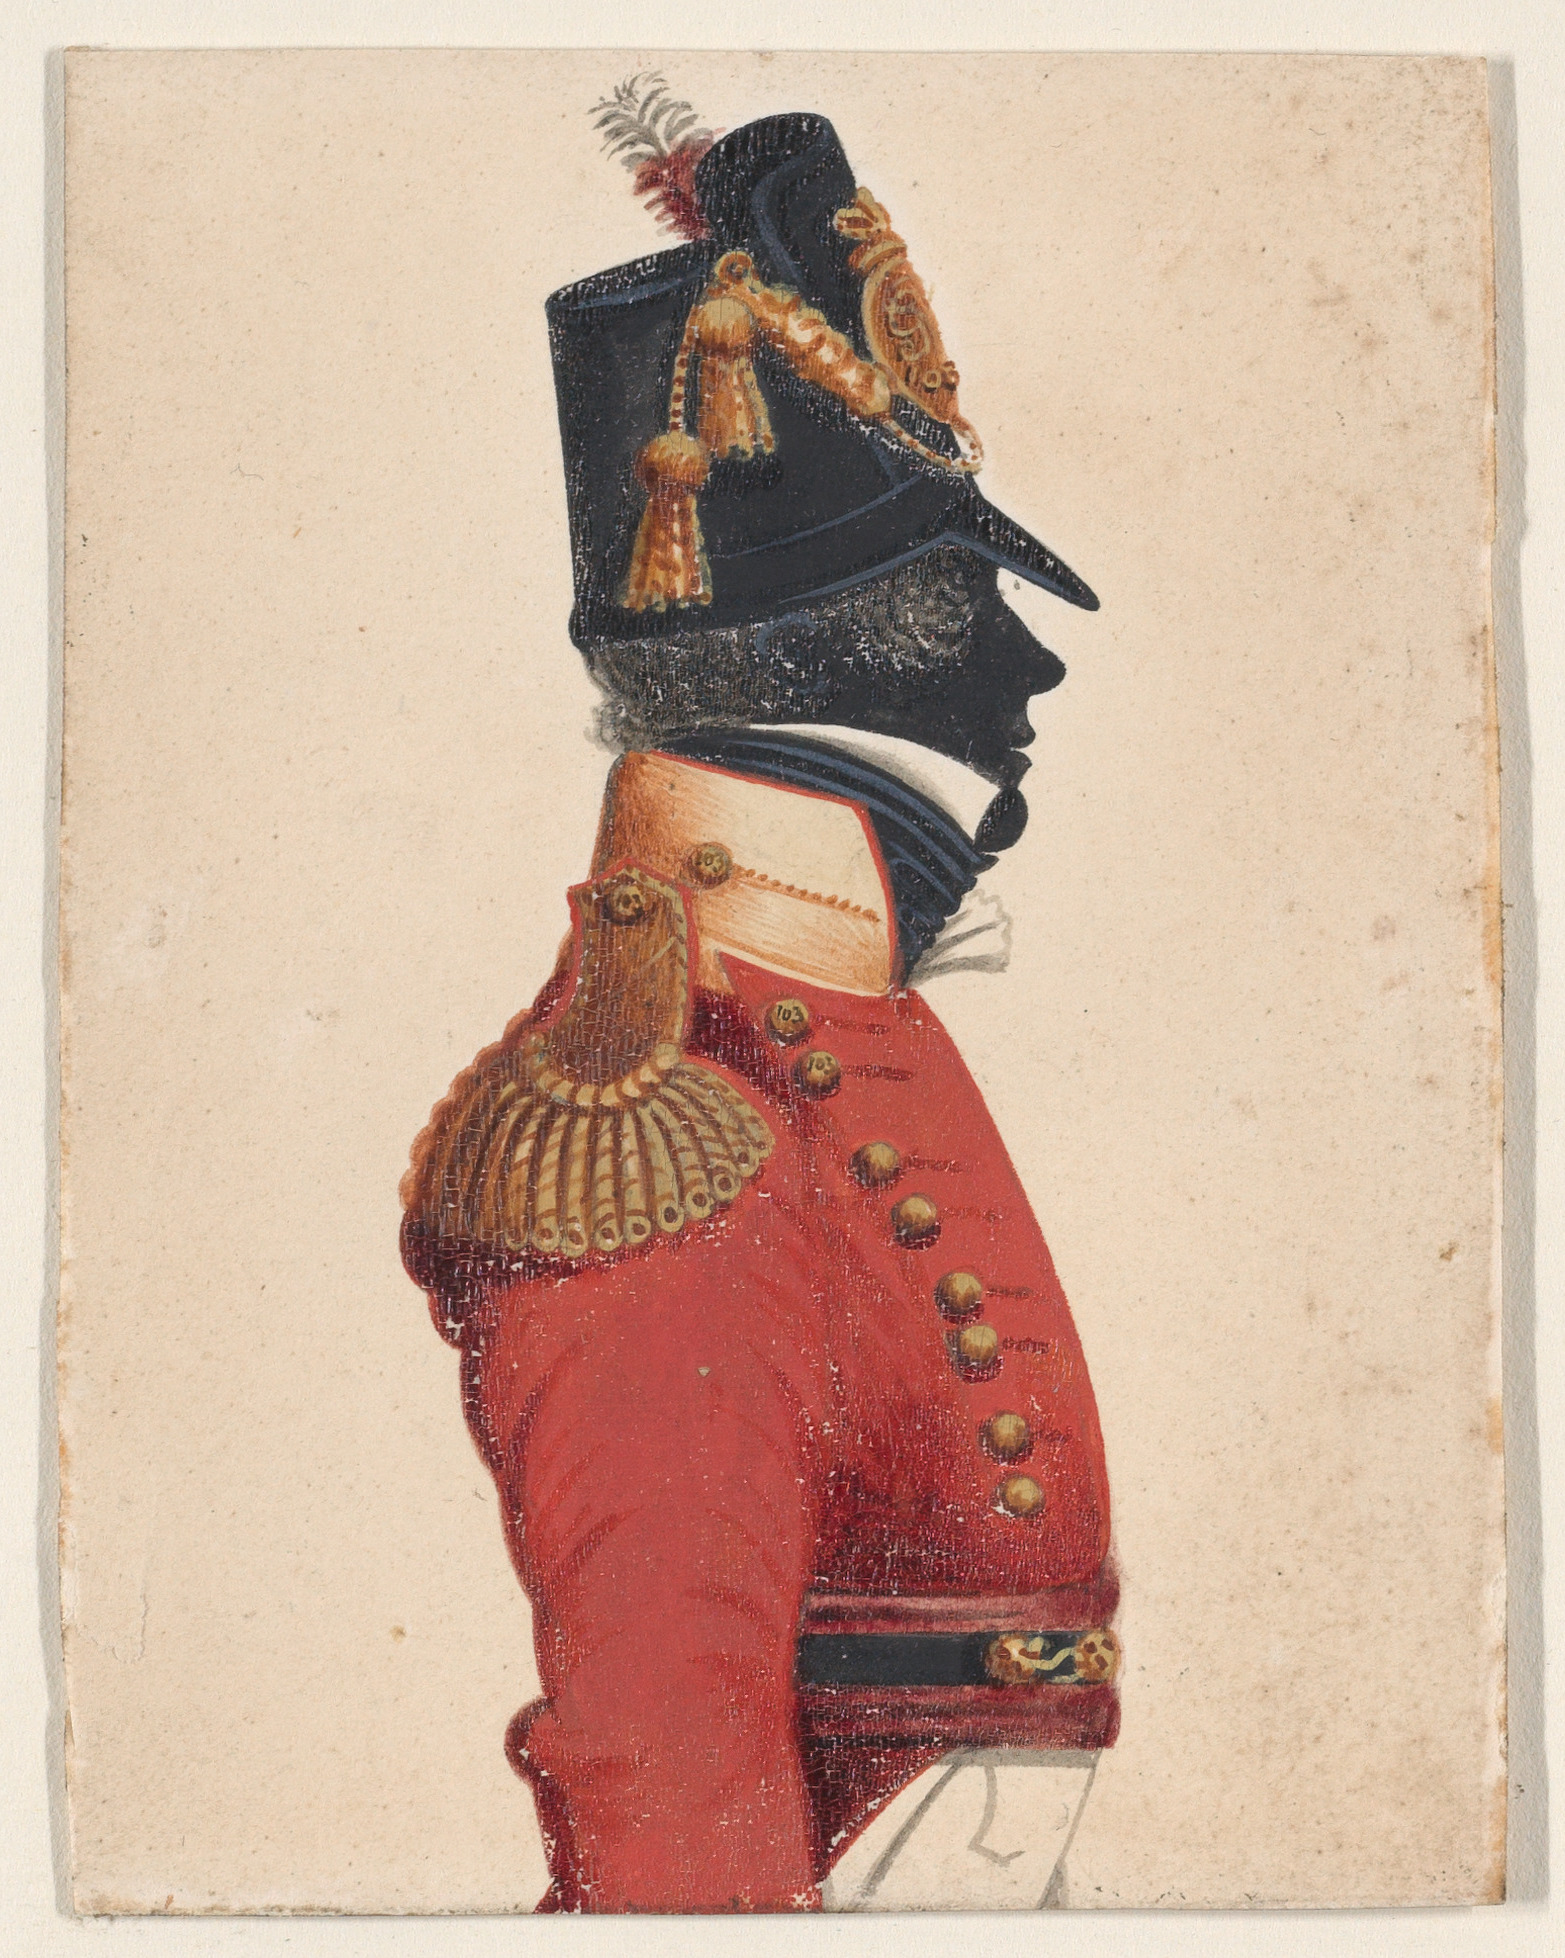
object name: drawing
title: Half-length silhouette of a young officer of the 103rd regiment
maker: john buncombe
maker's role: artist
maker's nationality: british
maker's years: 1804-1904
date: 1825-1900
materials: gouache, ink, watercolor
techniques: pen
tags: soldiers,men